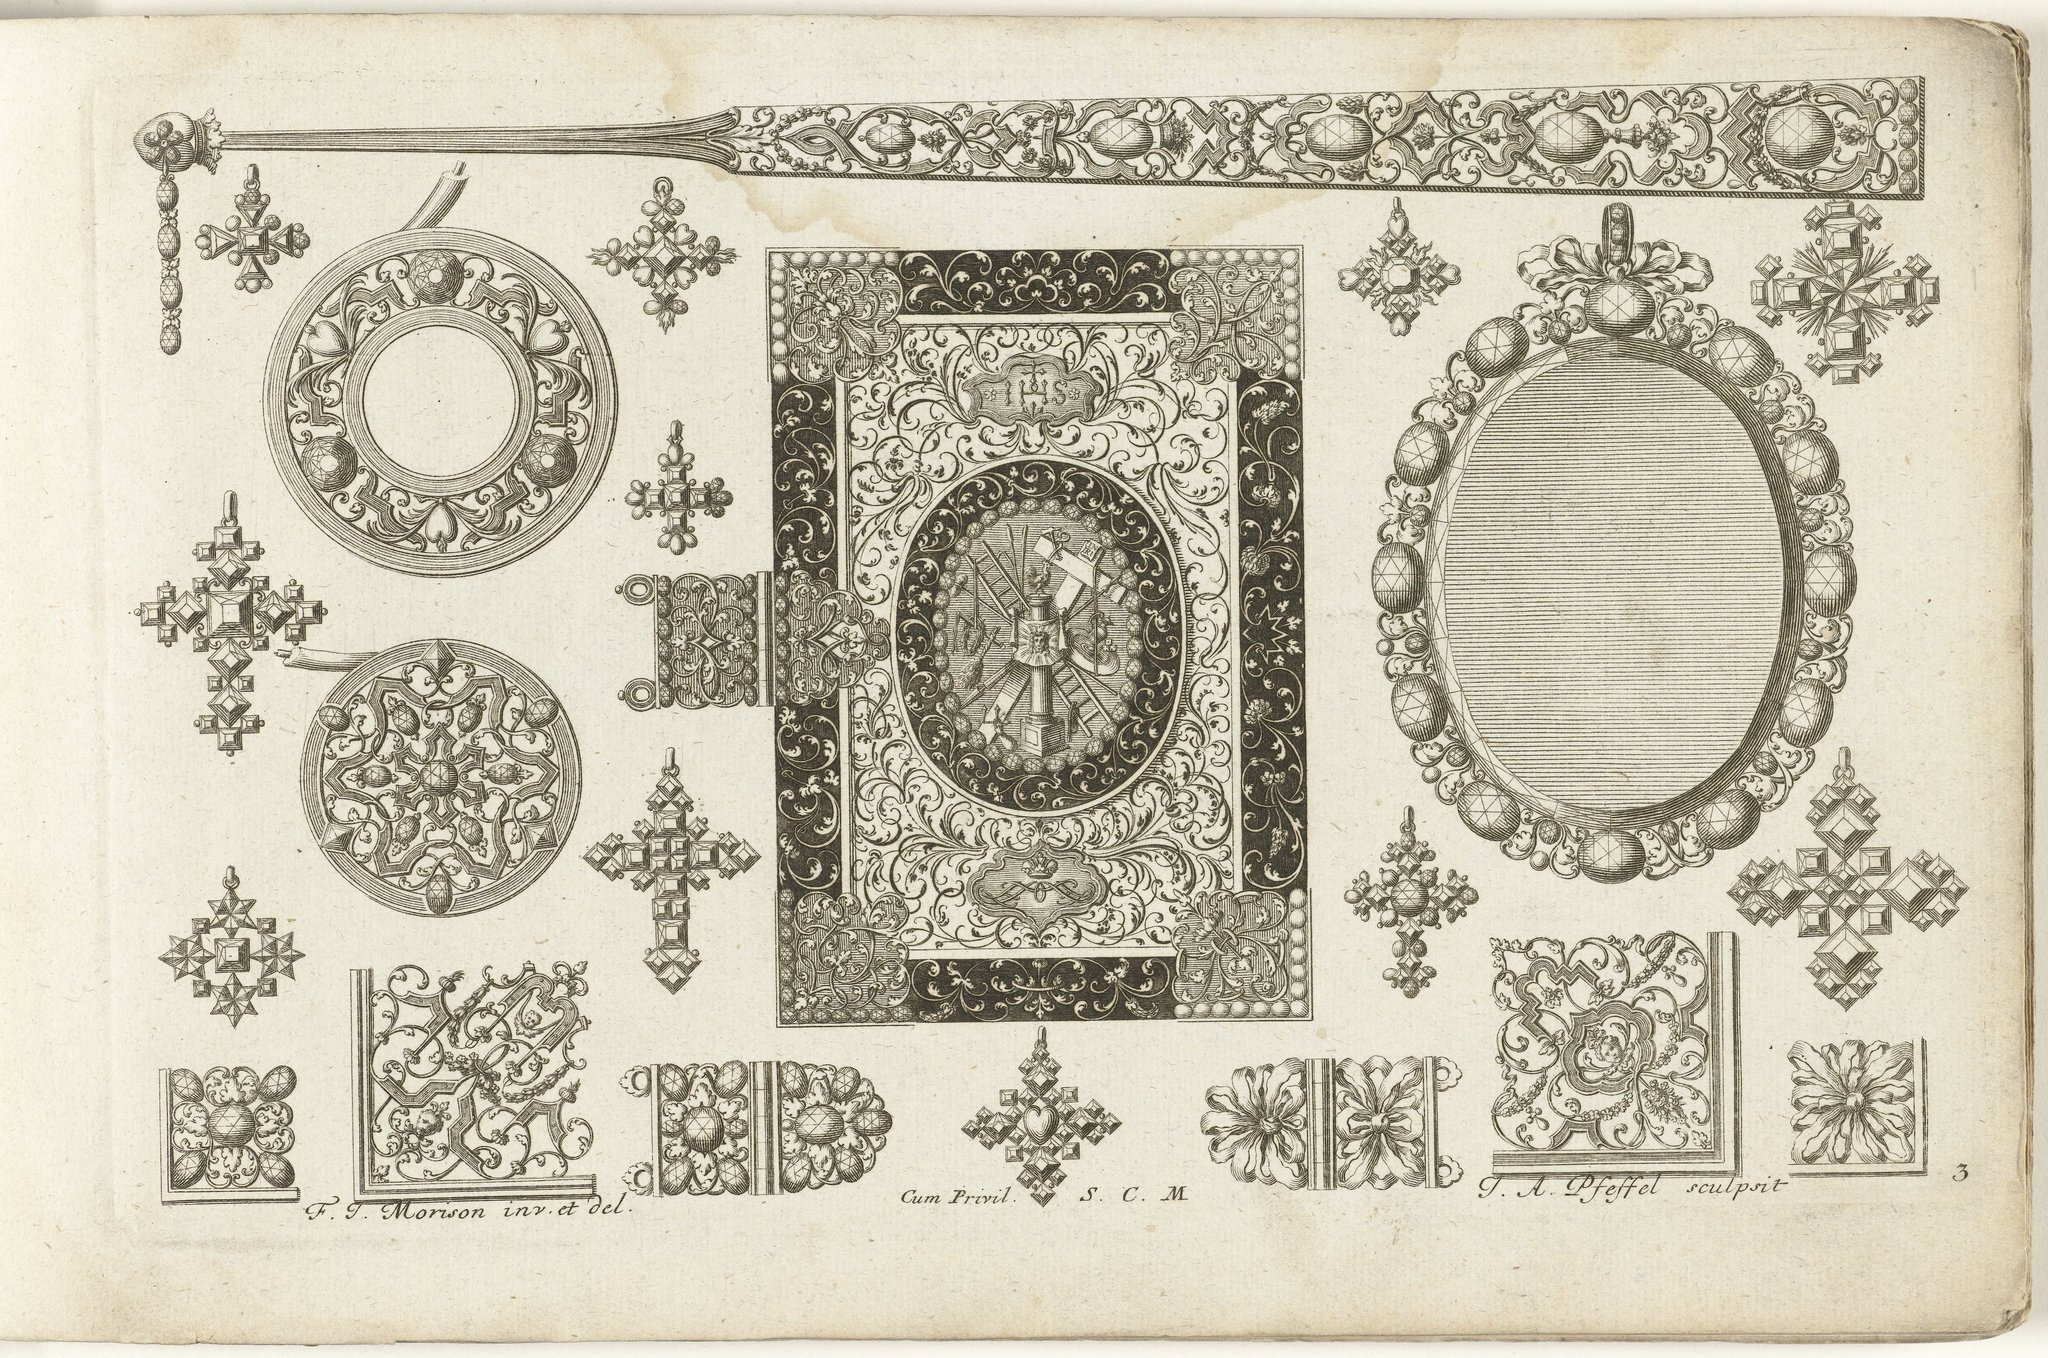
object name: print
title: Unterschiedliche neüe Inventionen von Geschmuckh, Zierathen und Galanterien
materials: paper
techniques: etching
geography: vienna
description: In het midden is een stofomslag afgebeeld, gedecoreerd met een trofee van de passieinstrumenten. Bovenaan bevindt zich het handvat van een waaier. Blad 3 uit serie van 8 bladen met ontwerpen voor juwelen met parels en edelstenen. Tweede editie.